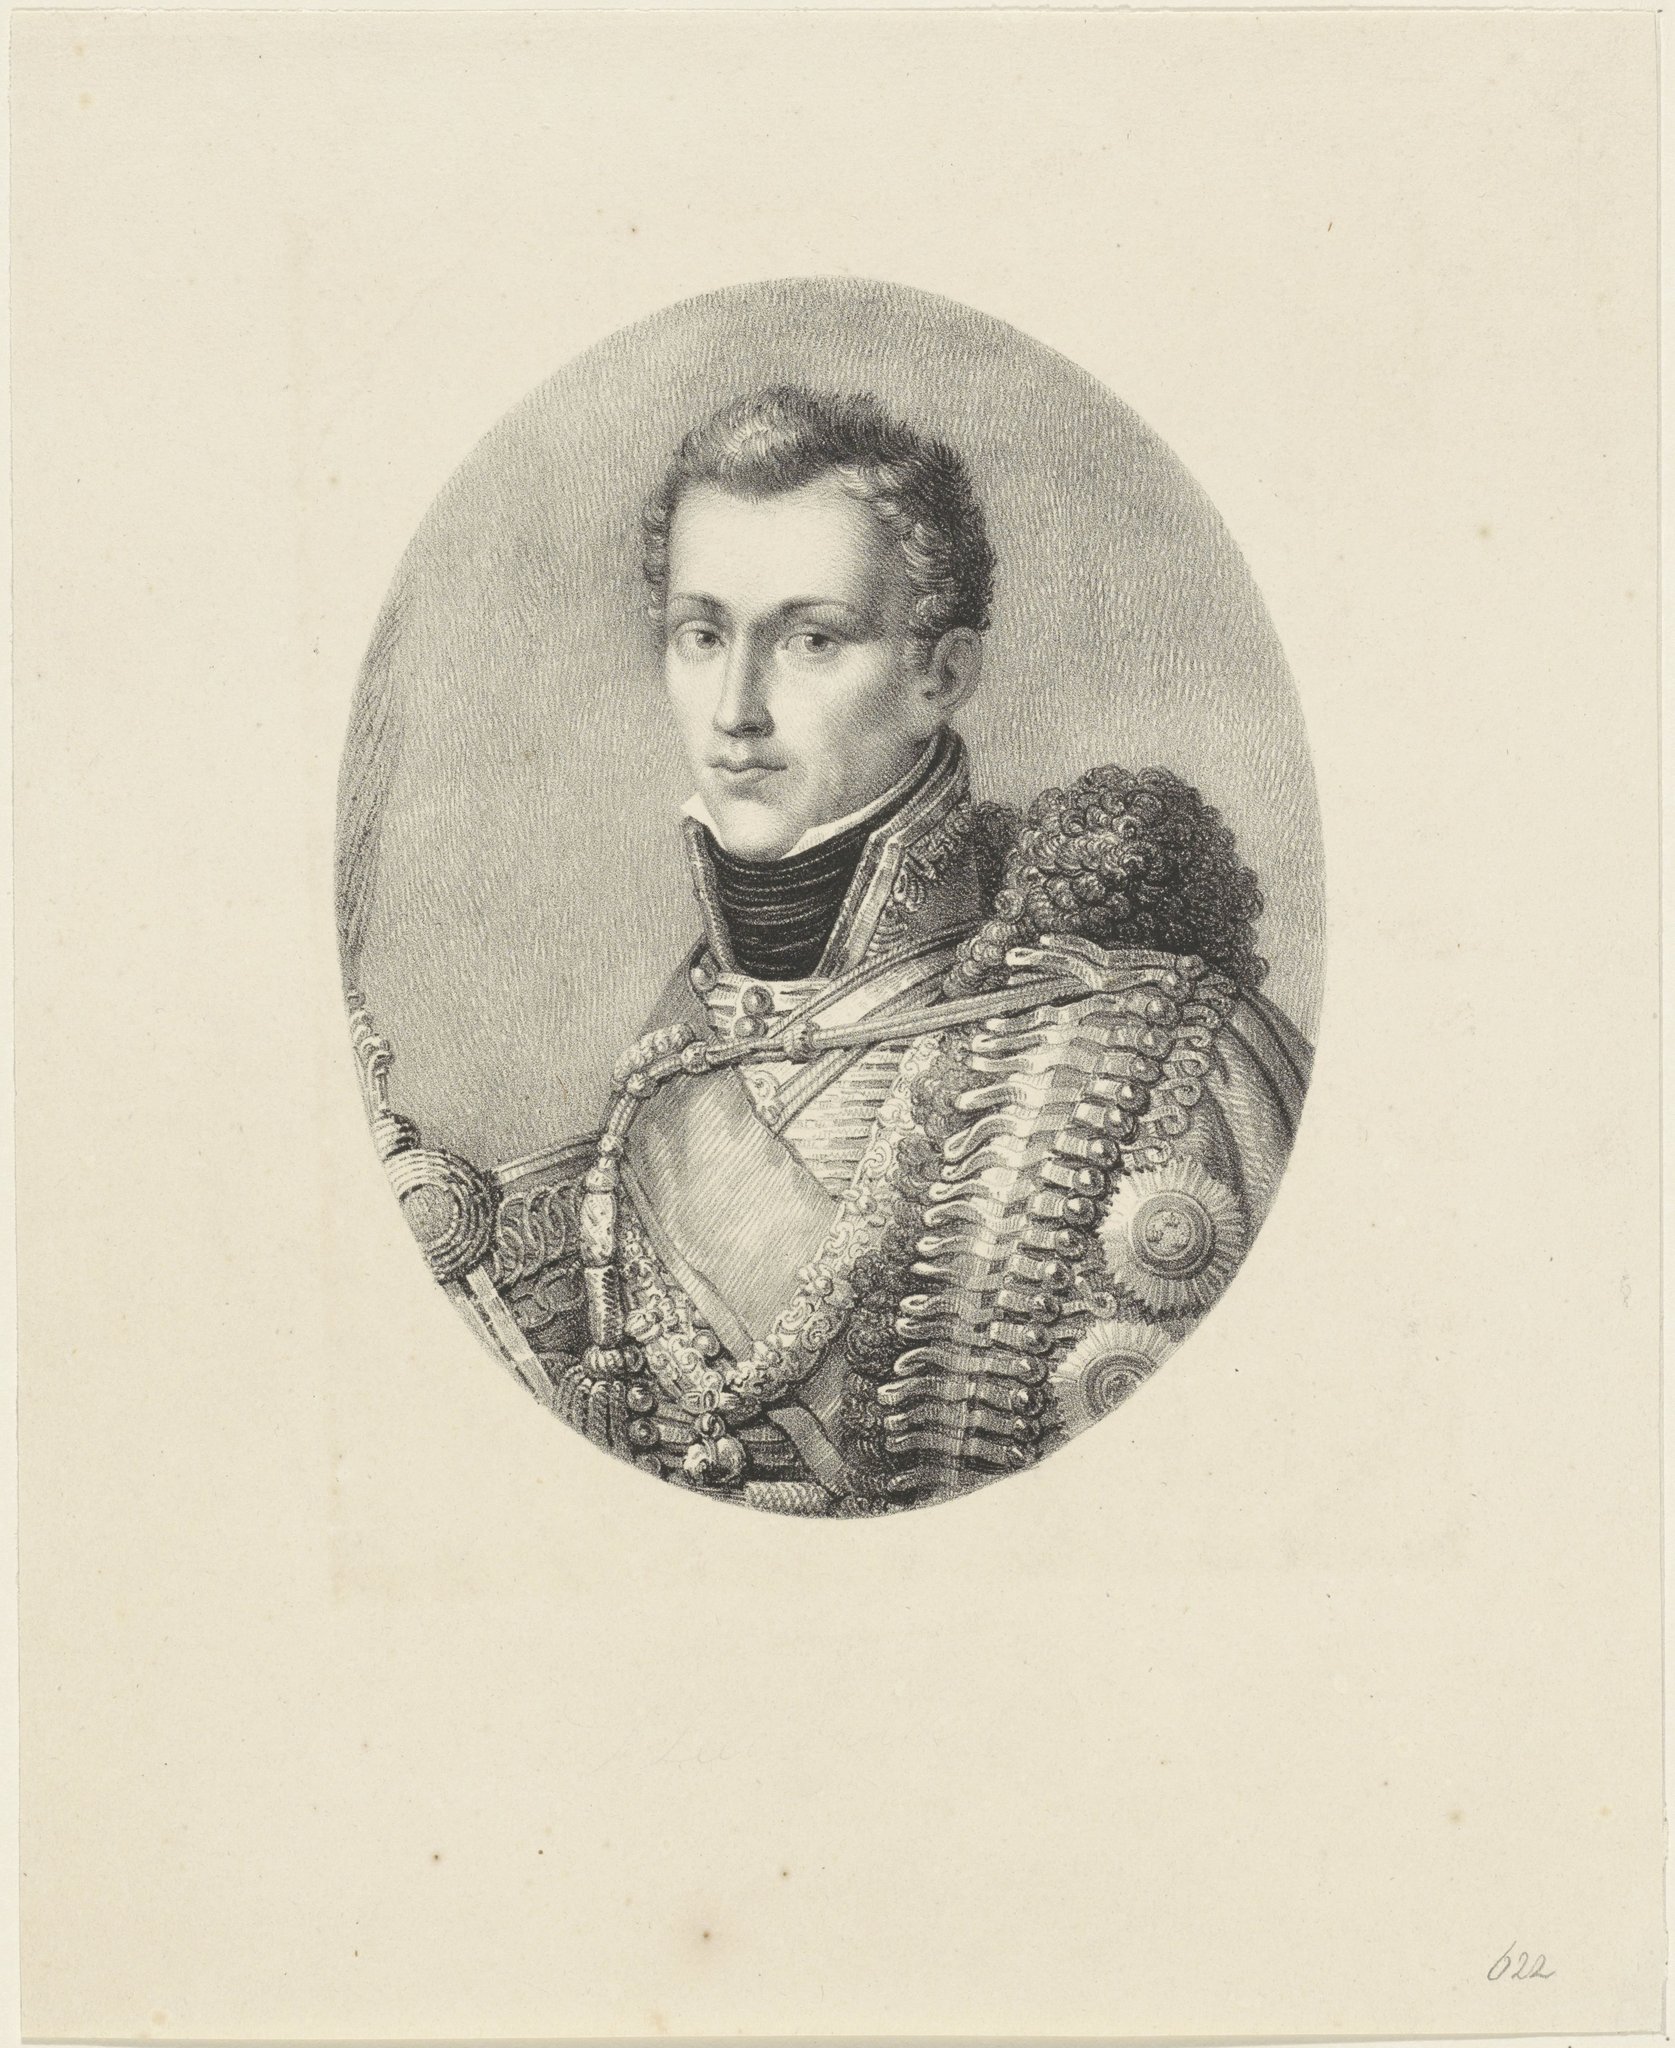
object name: print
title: Portret van Willem II, koning der Nederlanden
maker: m. j. v. duval de mercourt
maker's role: print maker, printer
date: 1818-1819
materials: paper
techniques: lithograph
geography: the hague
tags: the hague, william ii of the netherlands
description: De hier vermelde titel verwijst naar de hoogst verkregen titel van de geportretteerde, niet per se naar de titel die de geportretteerde op deze voorstelling draagt.